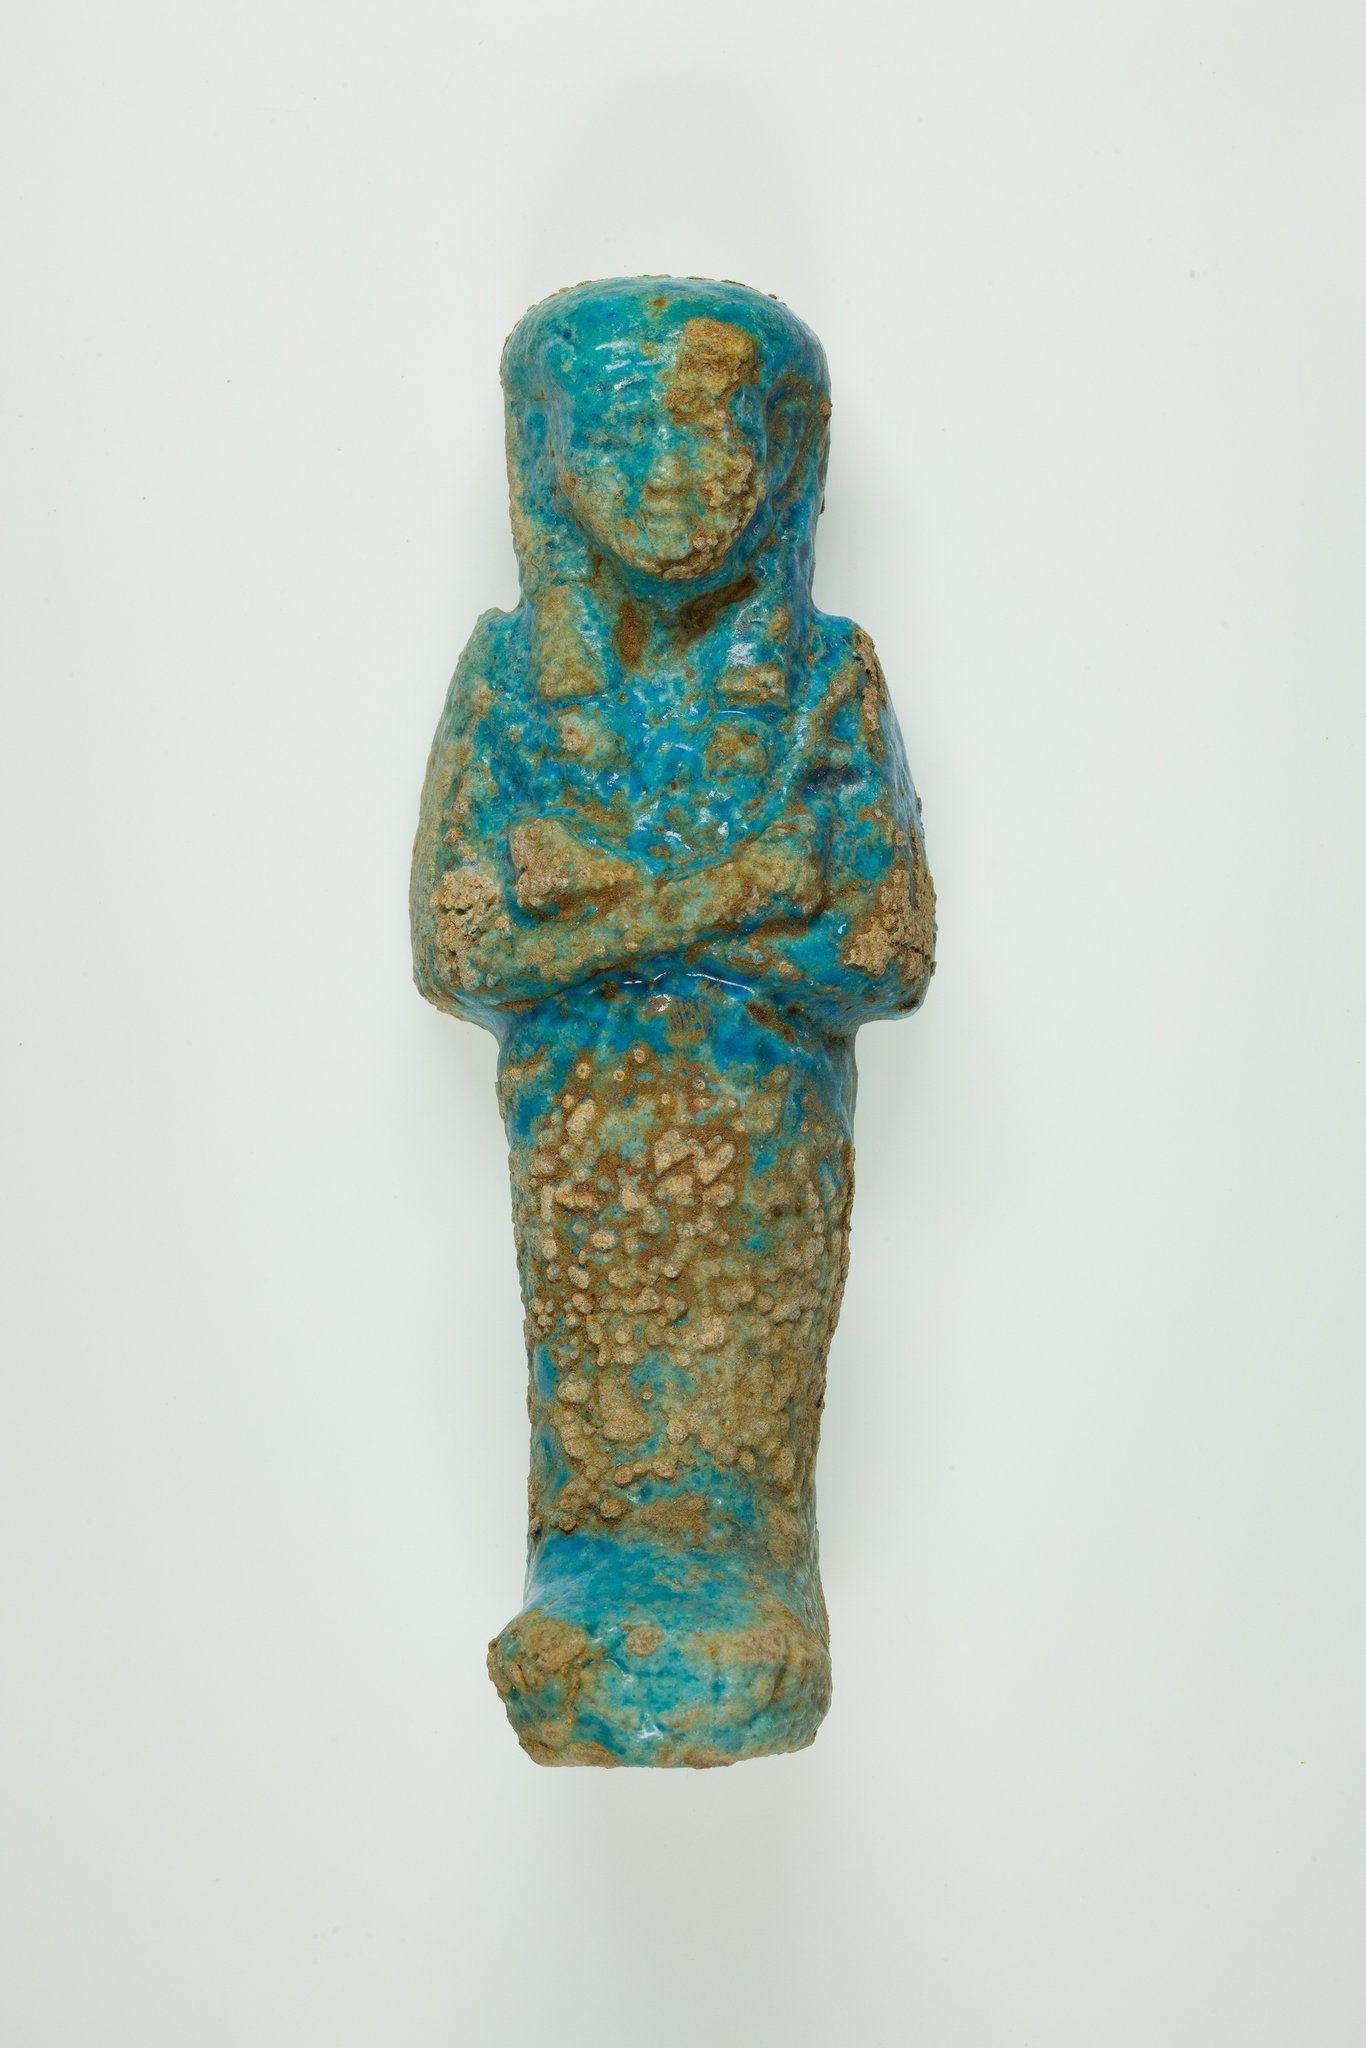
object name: worker shabti, henettawy c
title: Worker Shabti of Henettawy (C), Daughter of Isetemkheb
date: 990-970 BCE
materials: faience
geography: egypt